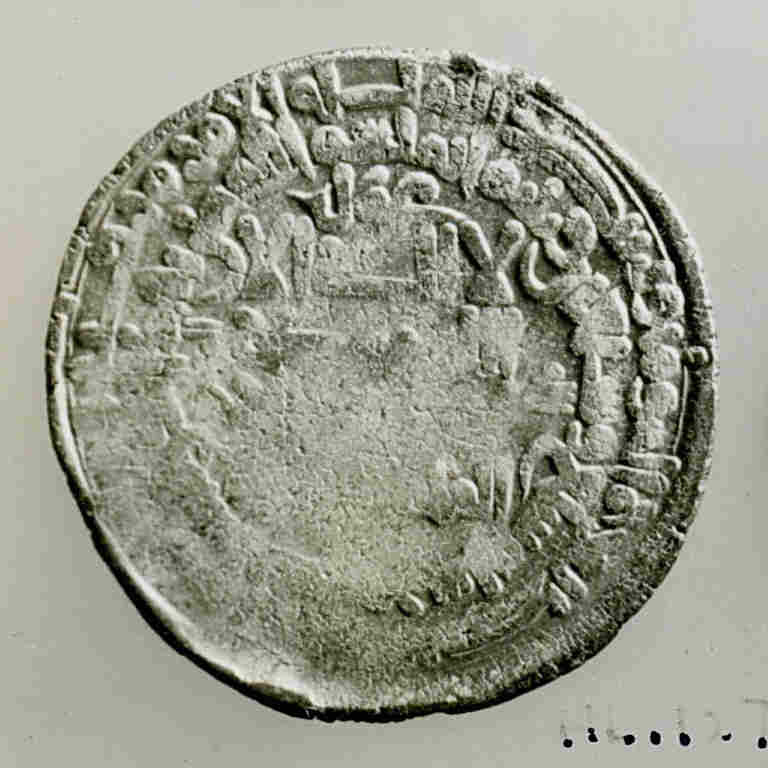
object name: coin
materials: silver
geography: iran